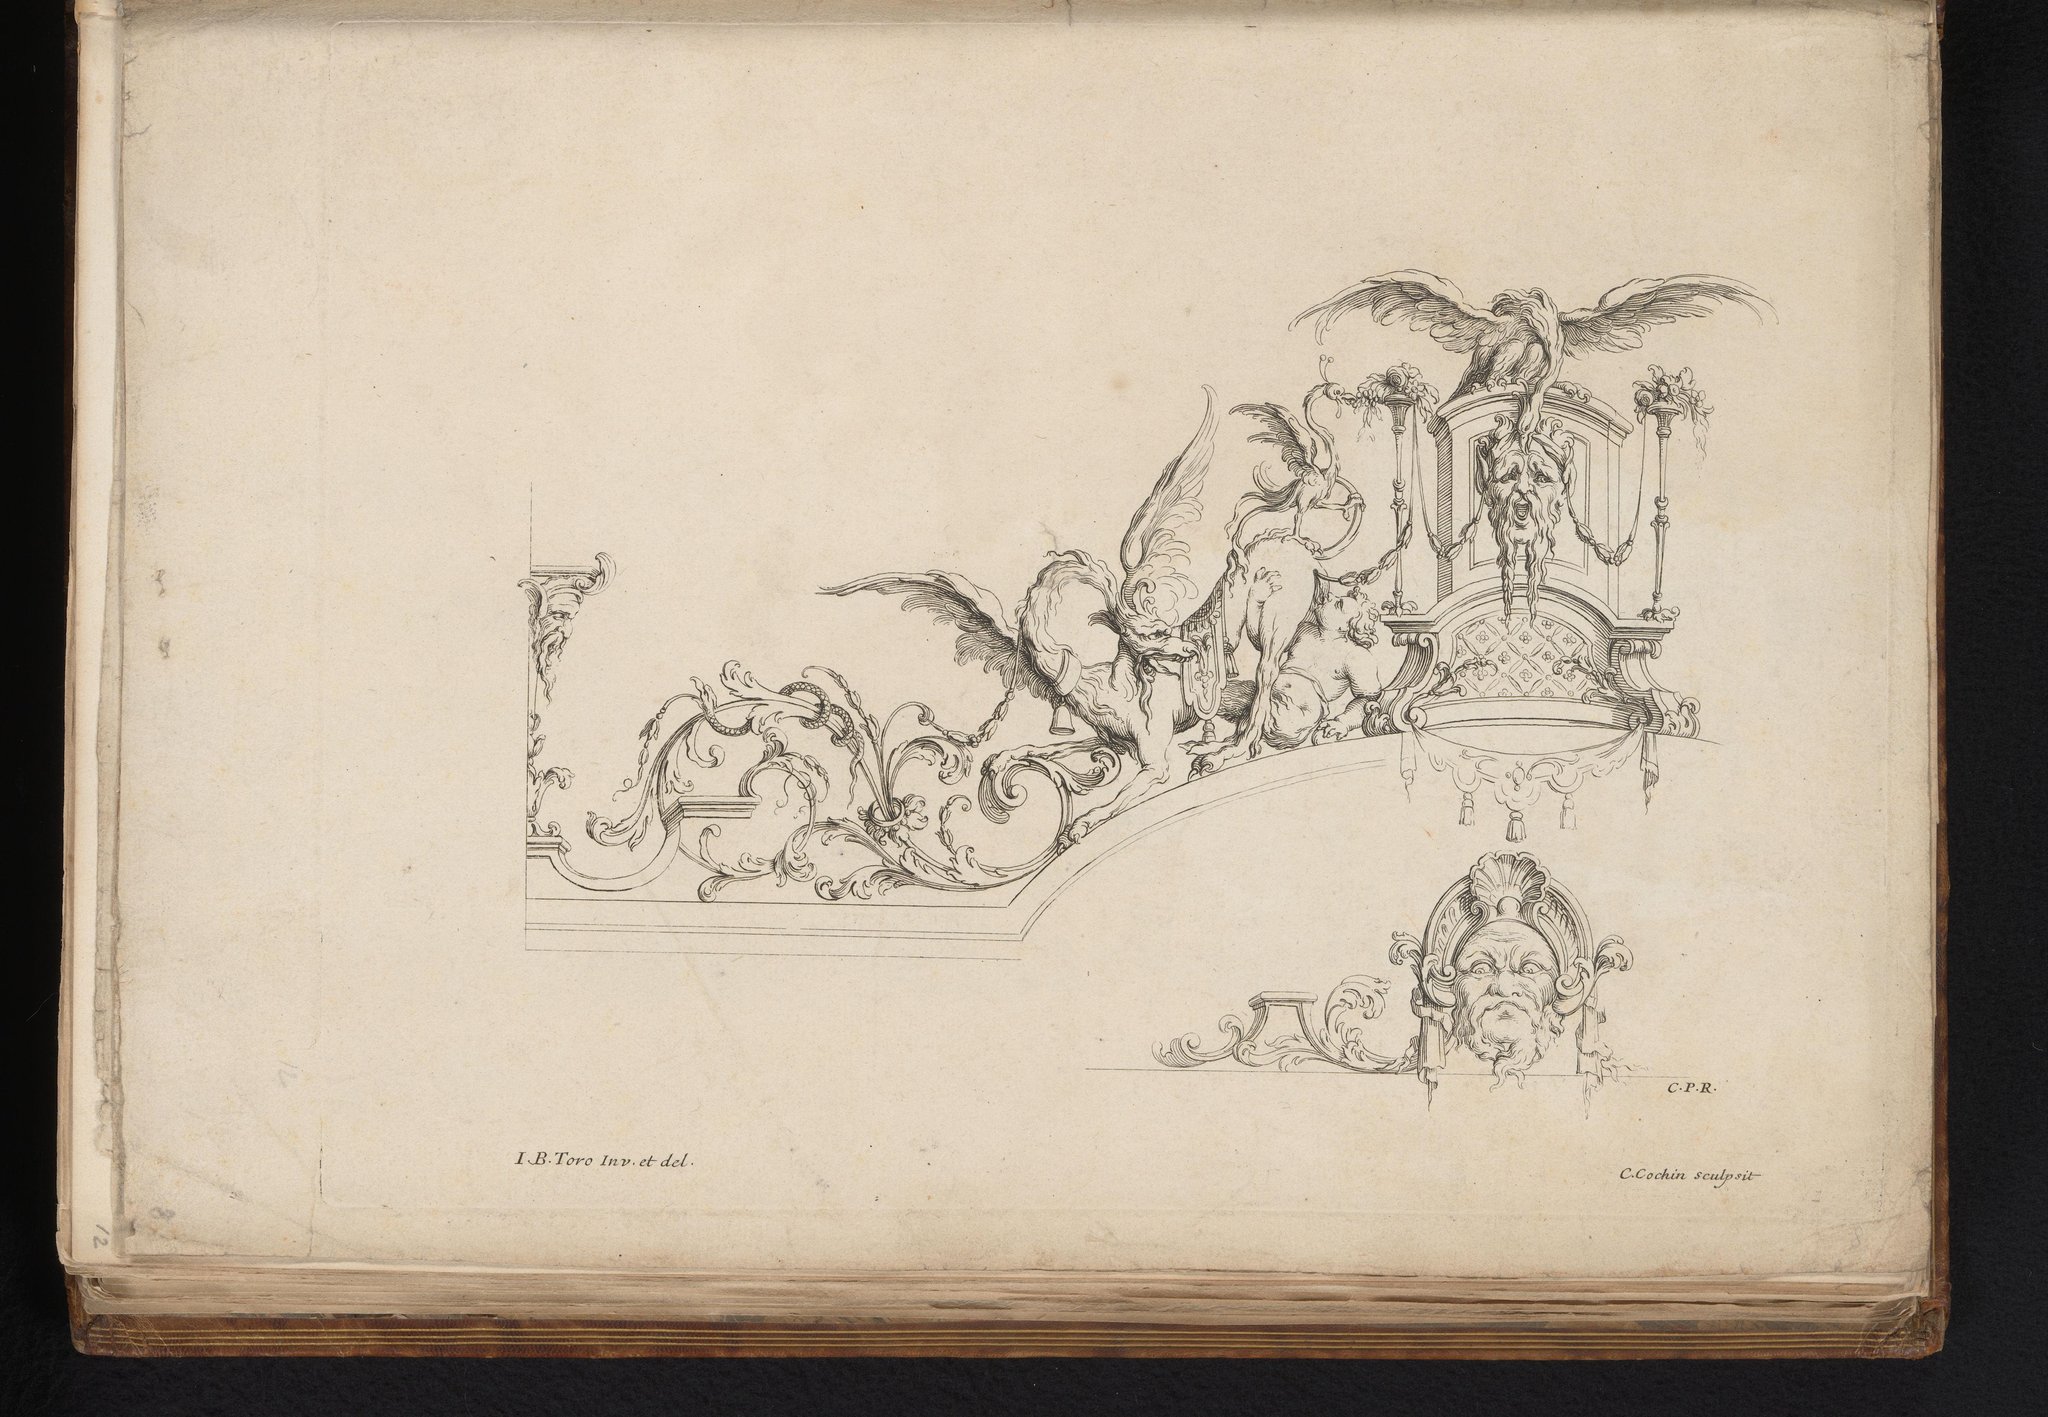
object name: print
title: Arabesk met fantasiewezen en adelaar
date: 1716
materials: paper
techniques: etching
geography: france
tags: fabulous animals (sometimes wrongly called 'grotesques'); 'mostri' (ripa), ornament ~ arabesque, satyr(s) (in general)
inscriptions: collector's mark: Lugt 2228, collector's mark: Lugt 2760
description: Prent maakt deel uit van een serie van zes prenten.